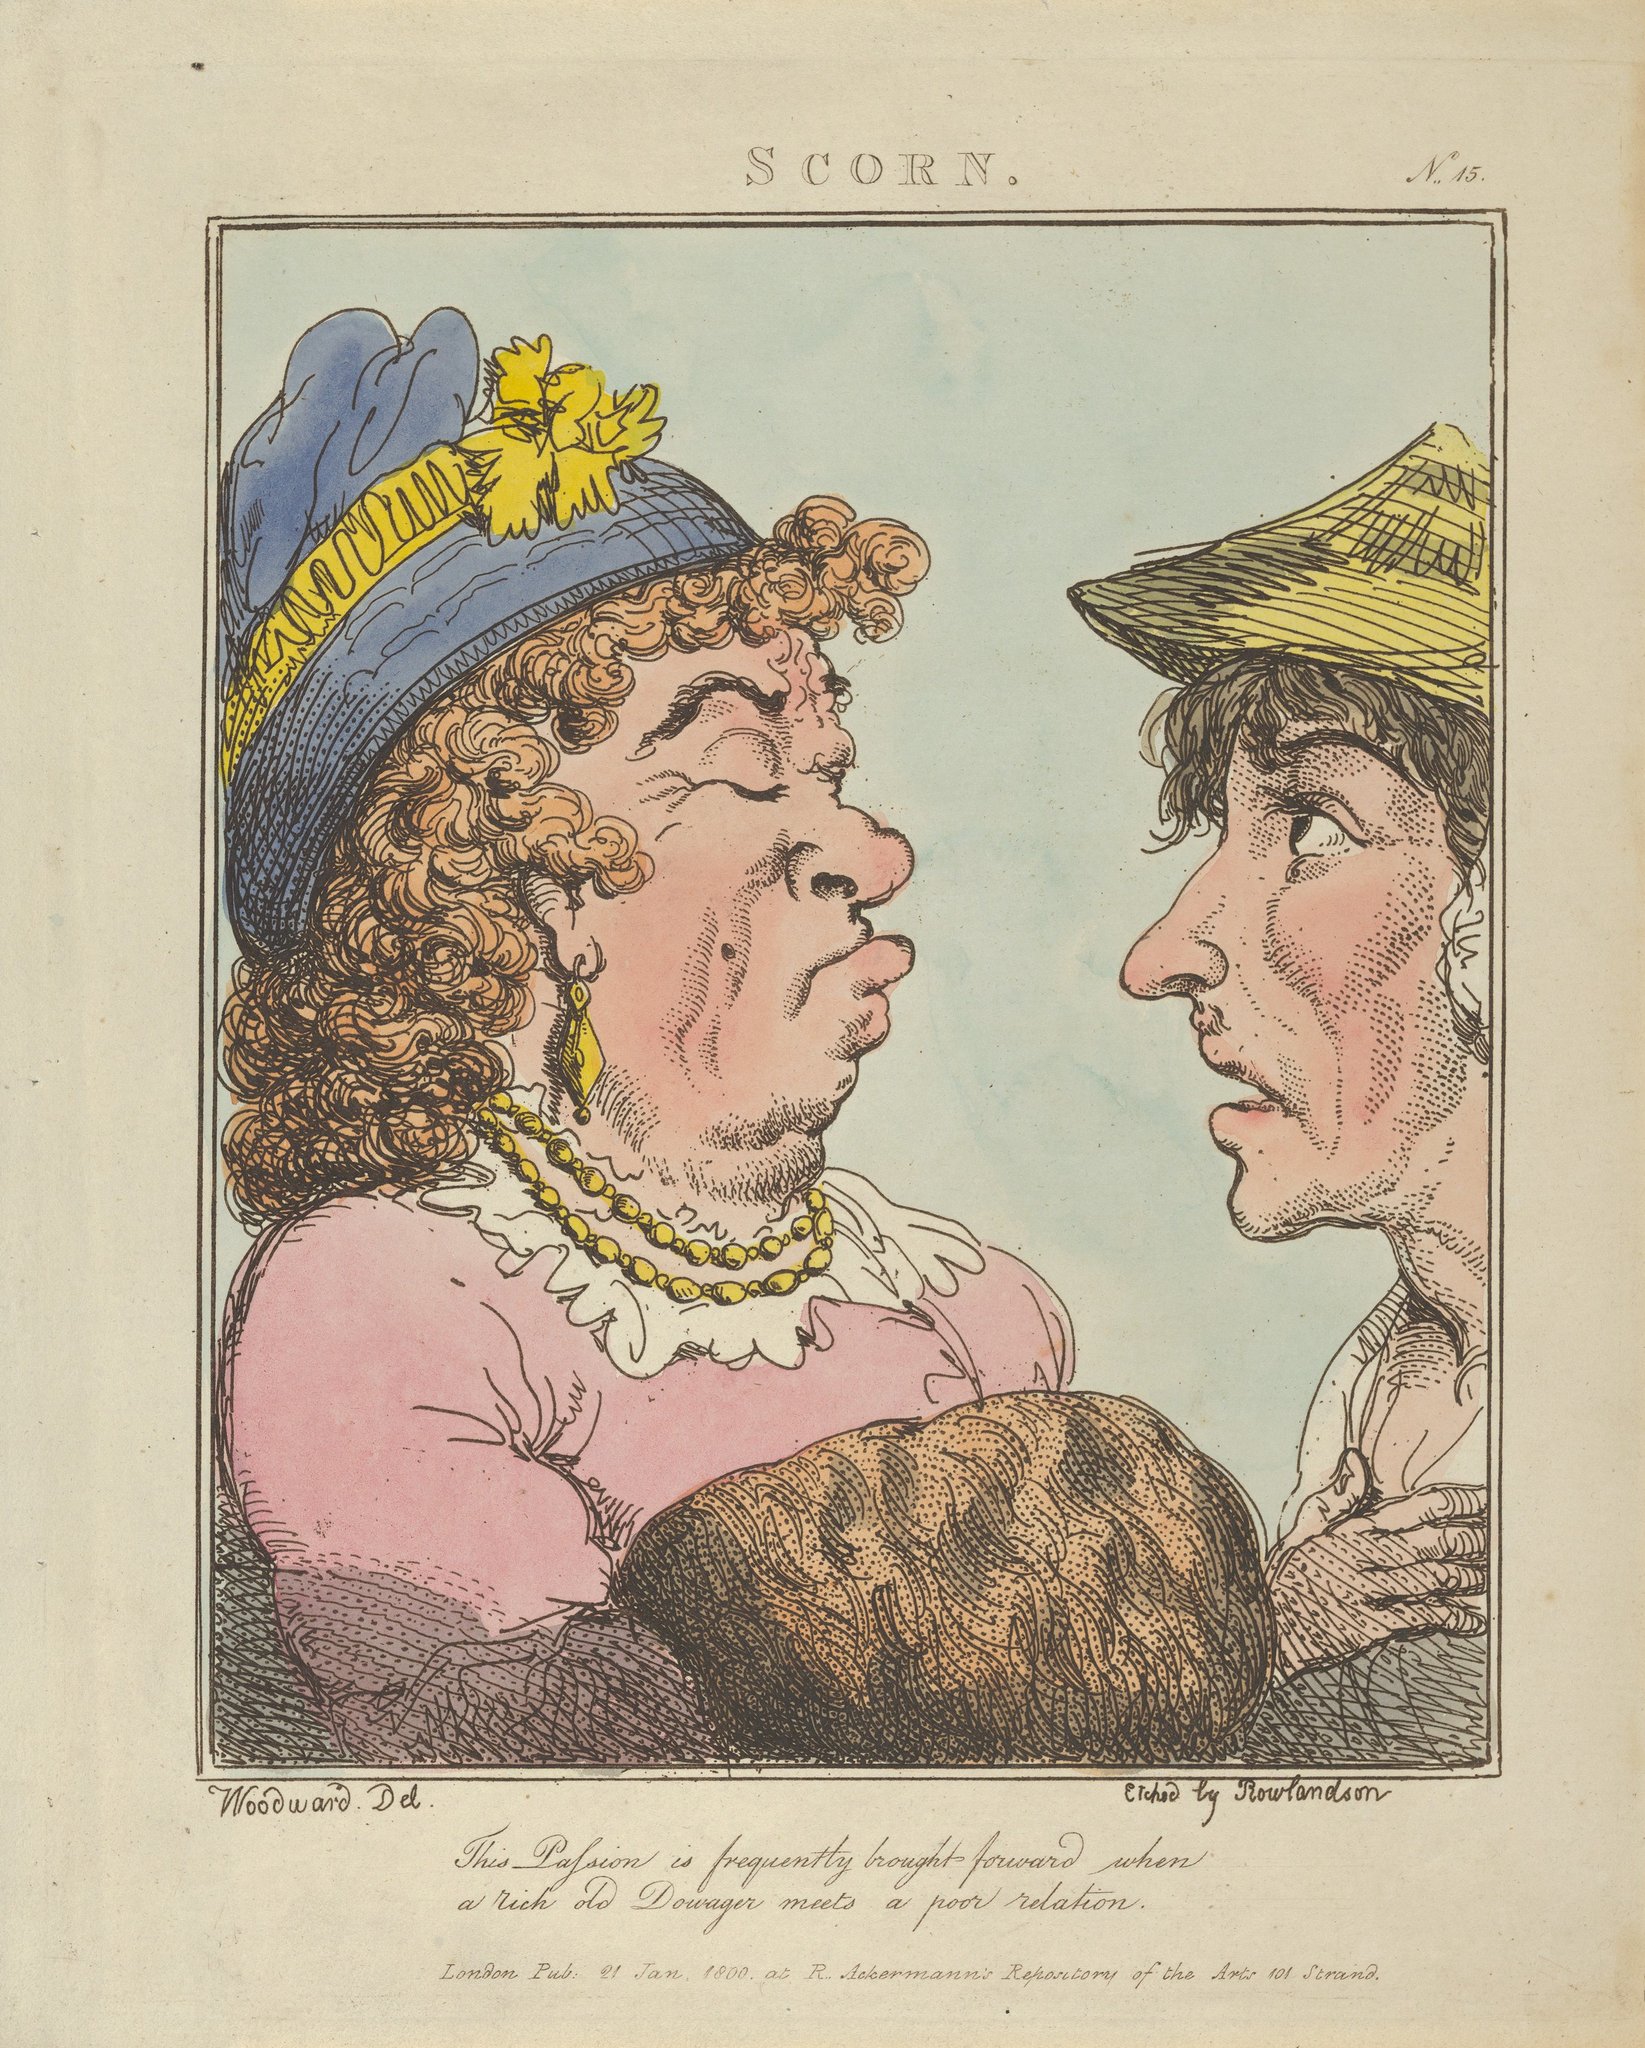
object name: print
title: Scorn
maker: thomas rowlandson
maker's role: artist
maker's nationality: british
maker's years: 1757-1827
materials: ink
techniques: etching, printing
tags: men,women